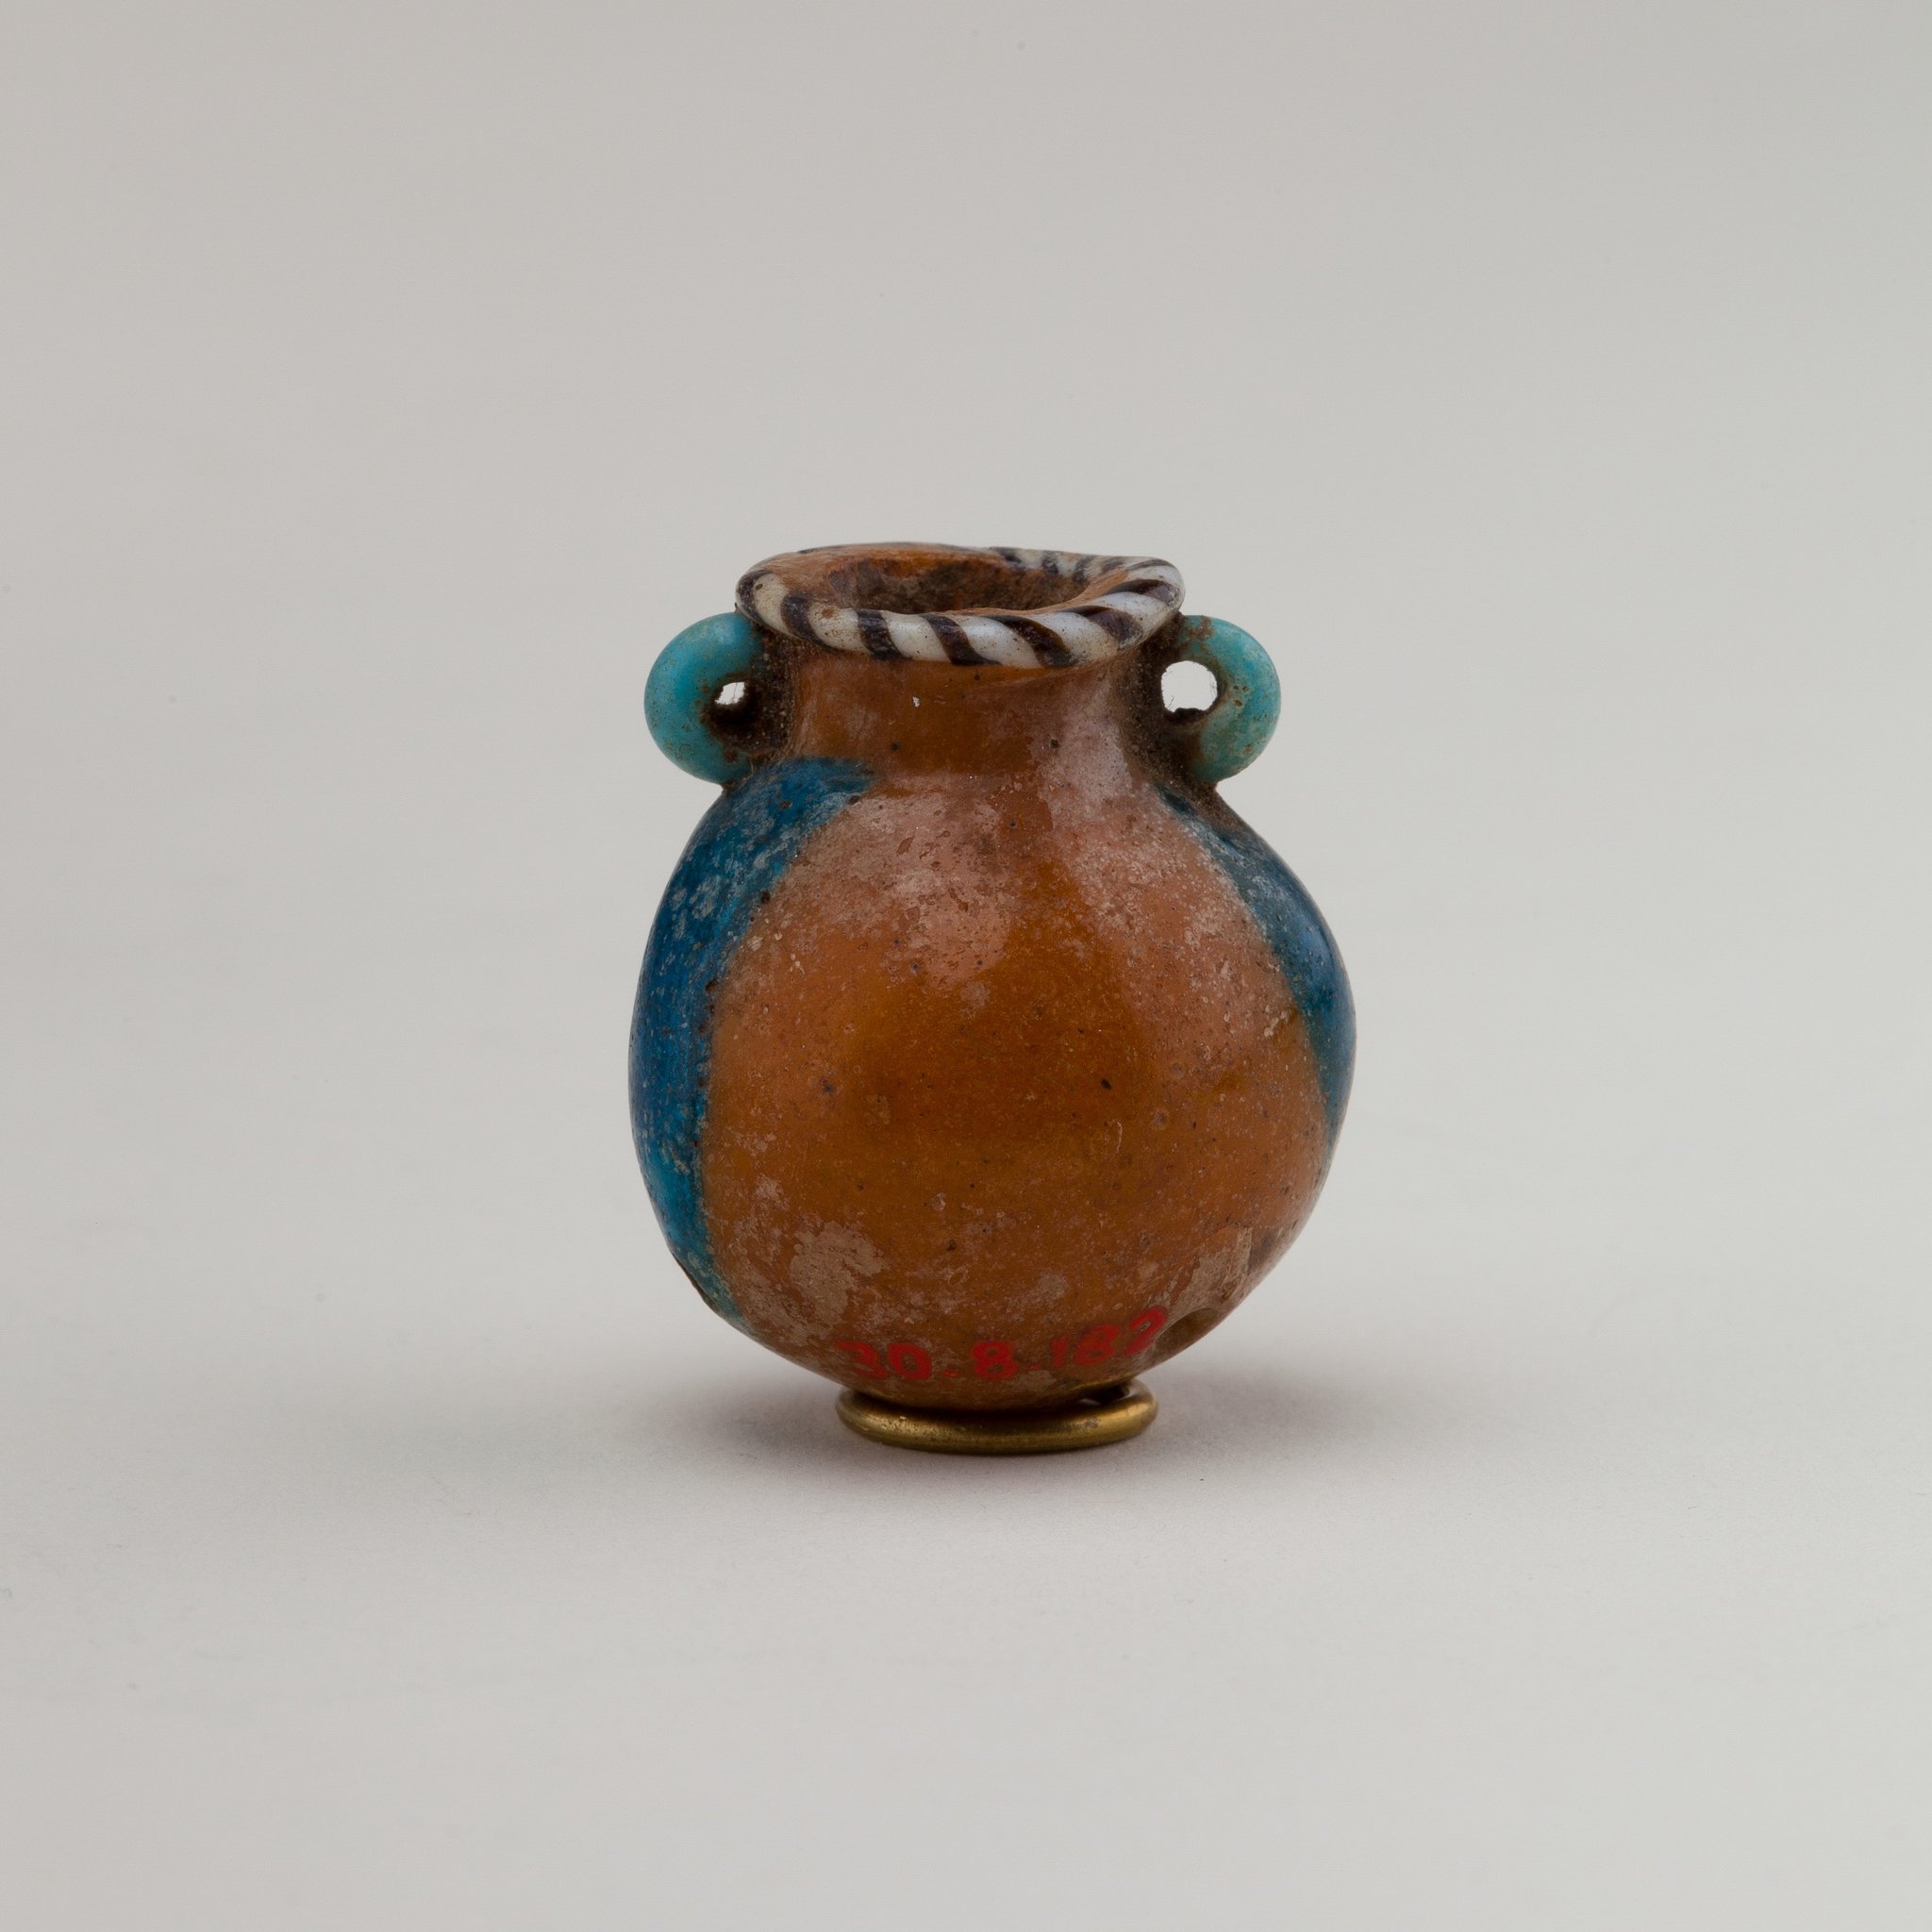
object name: bottle, miniature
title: Miniature Bottle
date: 1295-1070 BCE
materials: glass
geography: egypt